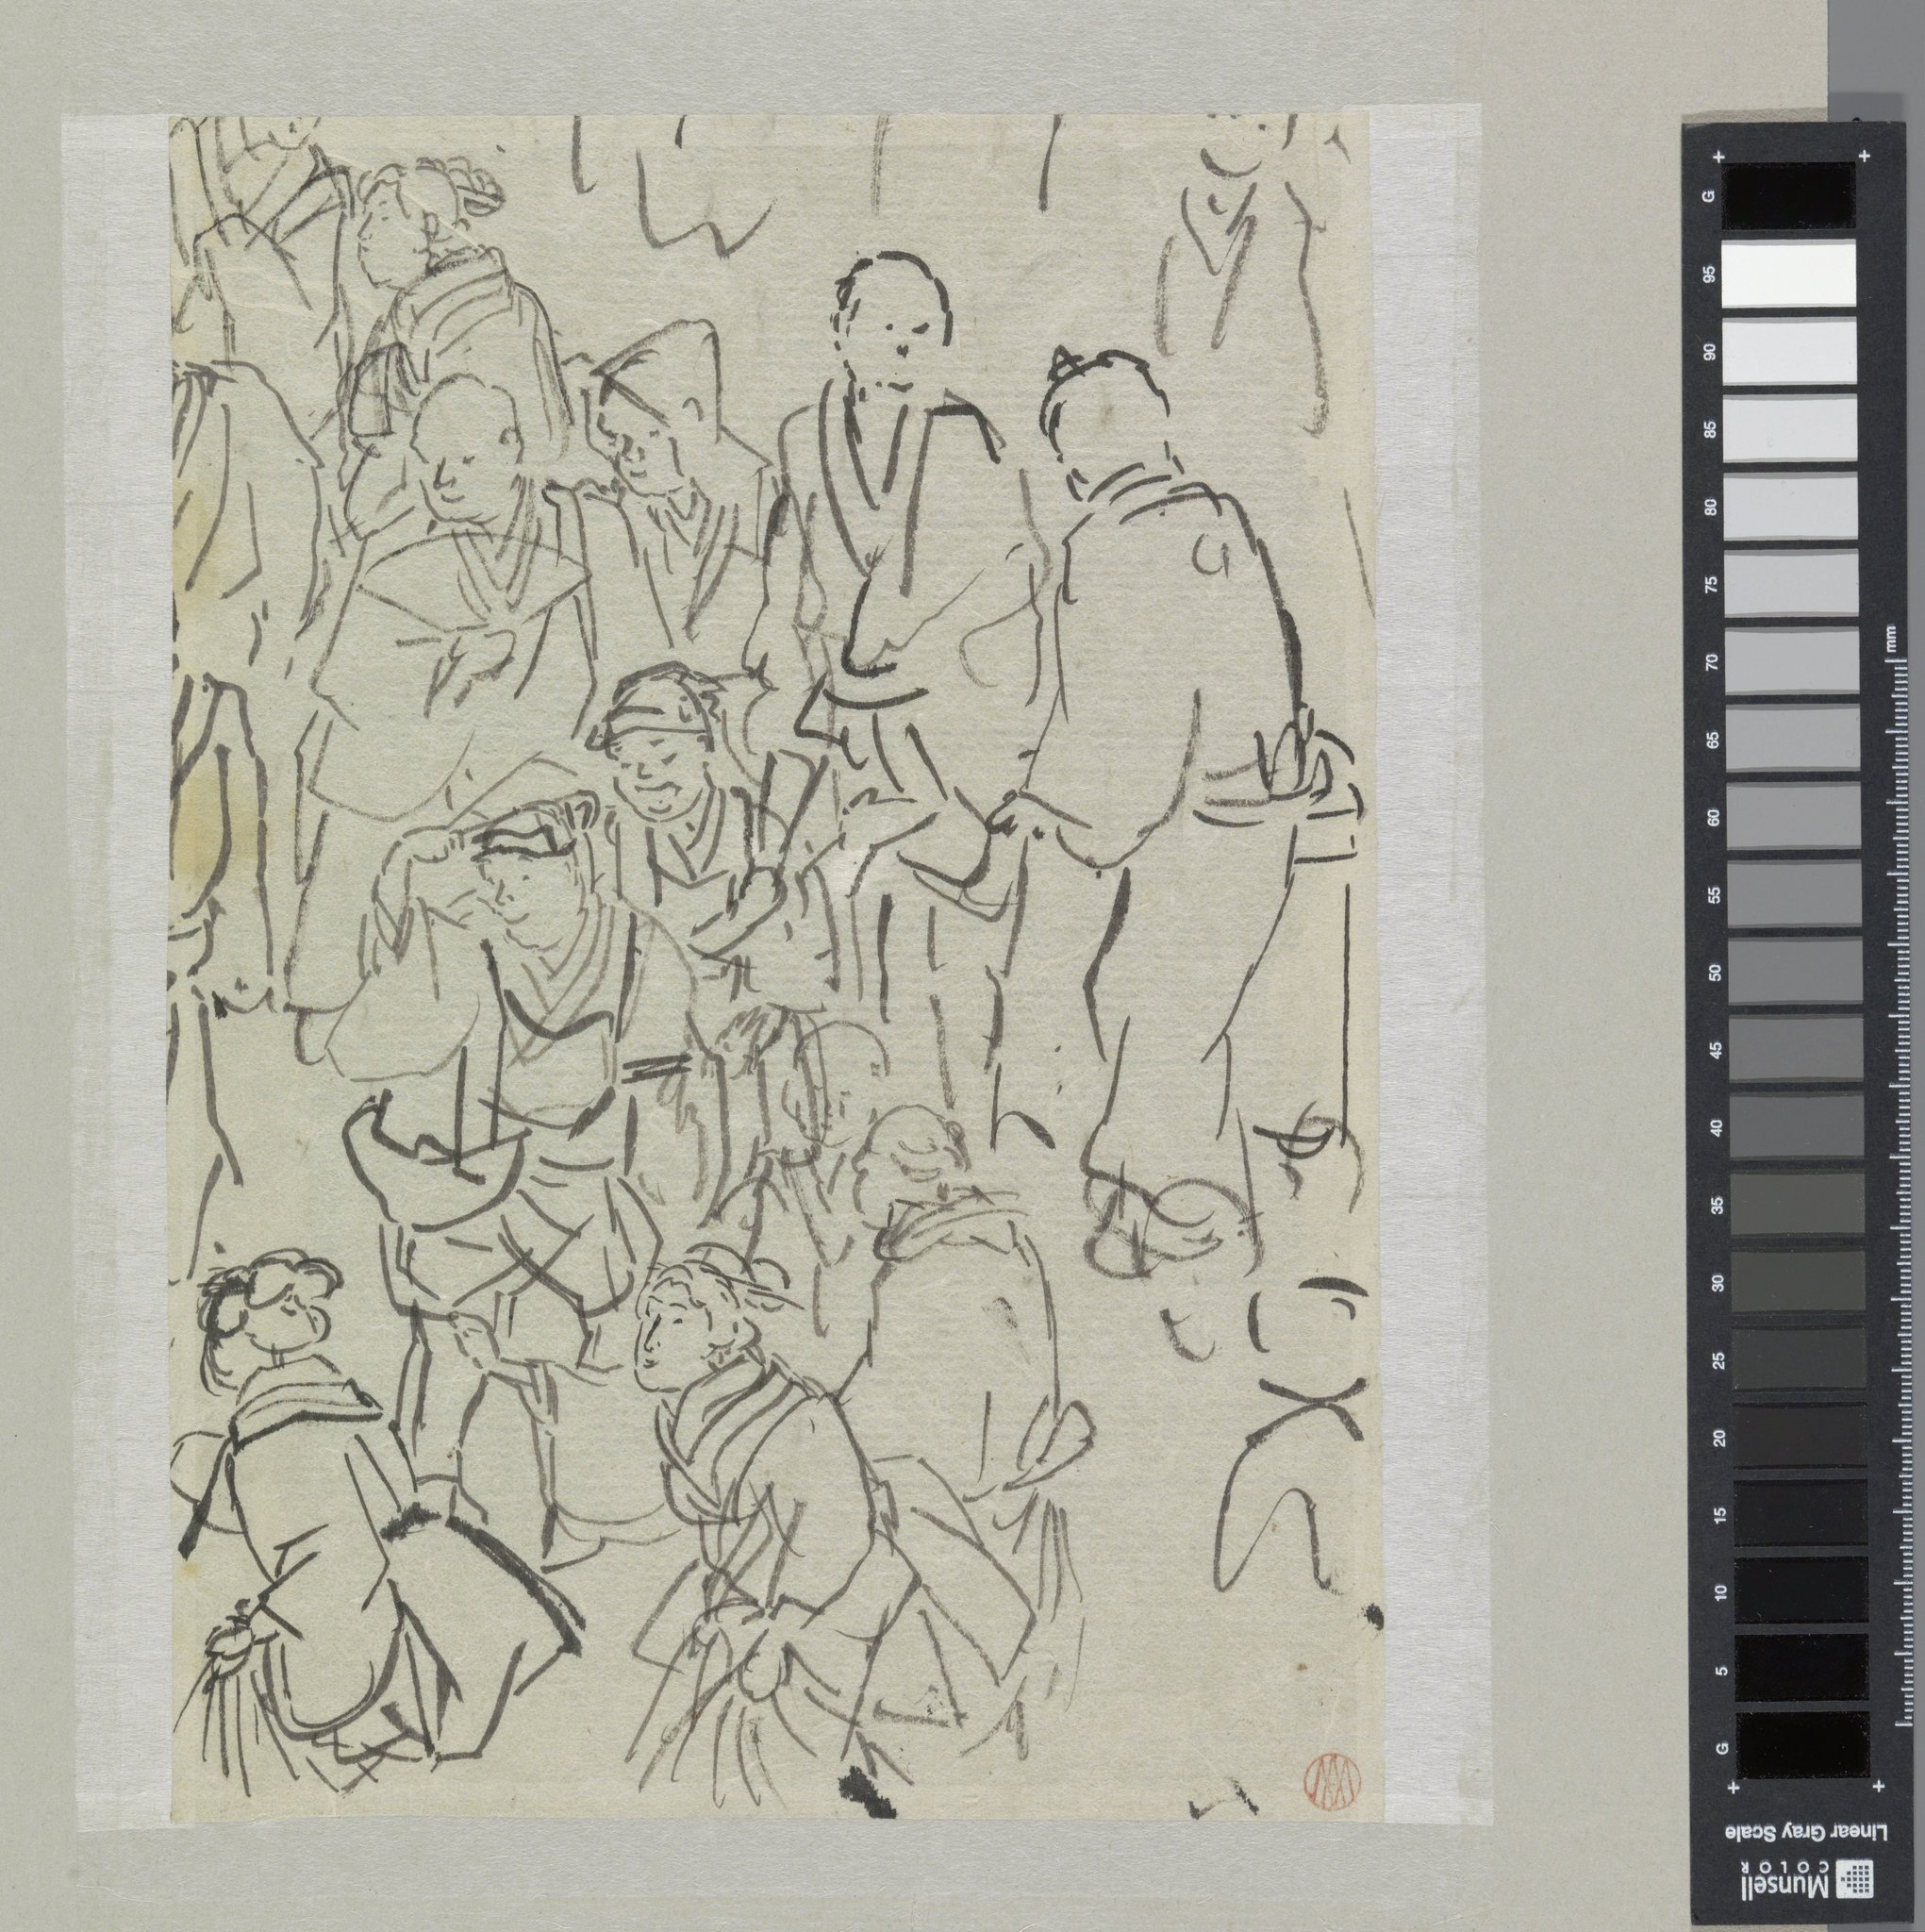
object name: drawing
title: Straat tafereel, met ondere andere man met waaier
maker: utagawa kuniyoshi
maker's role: draughtsman, print maker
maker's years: 1798-1861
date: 1808-1861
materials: paper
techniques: brush